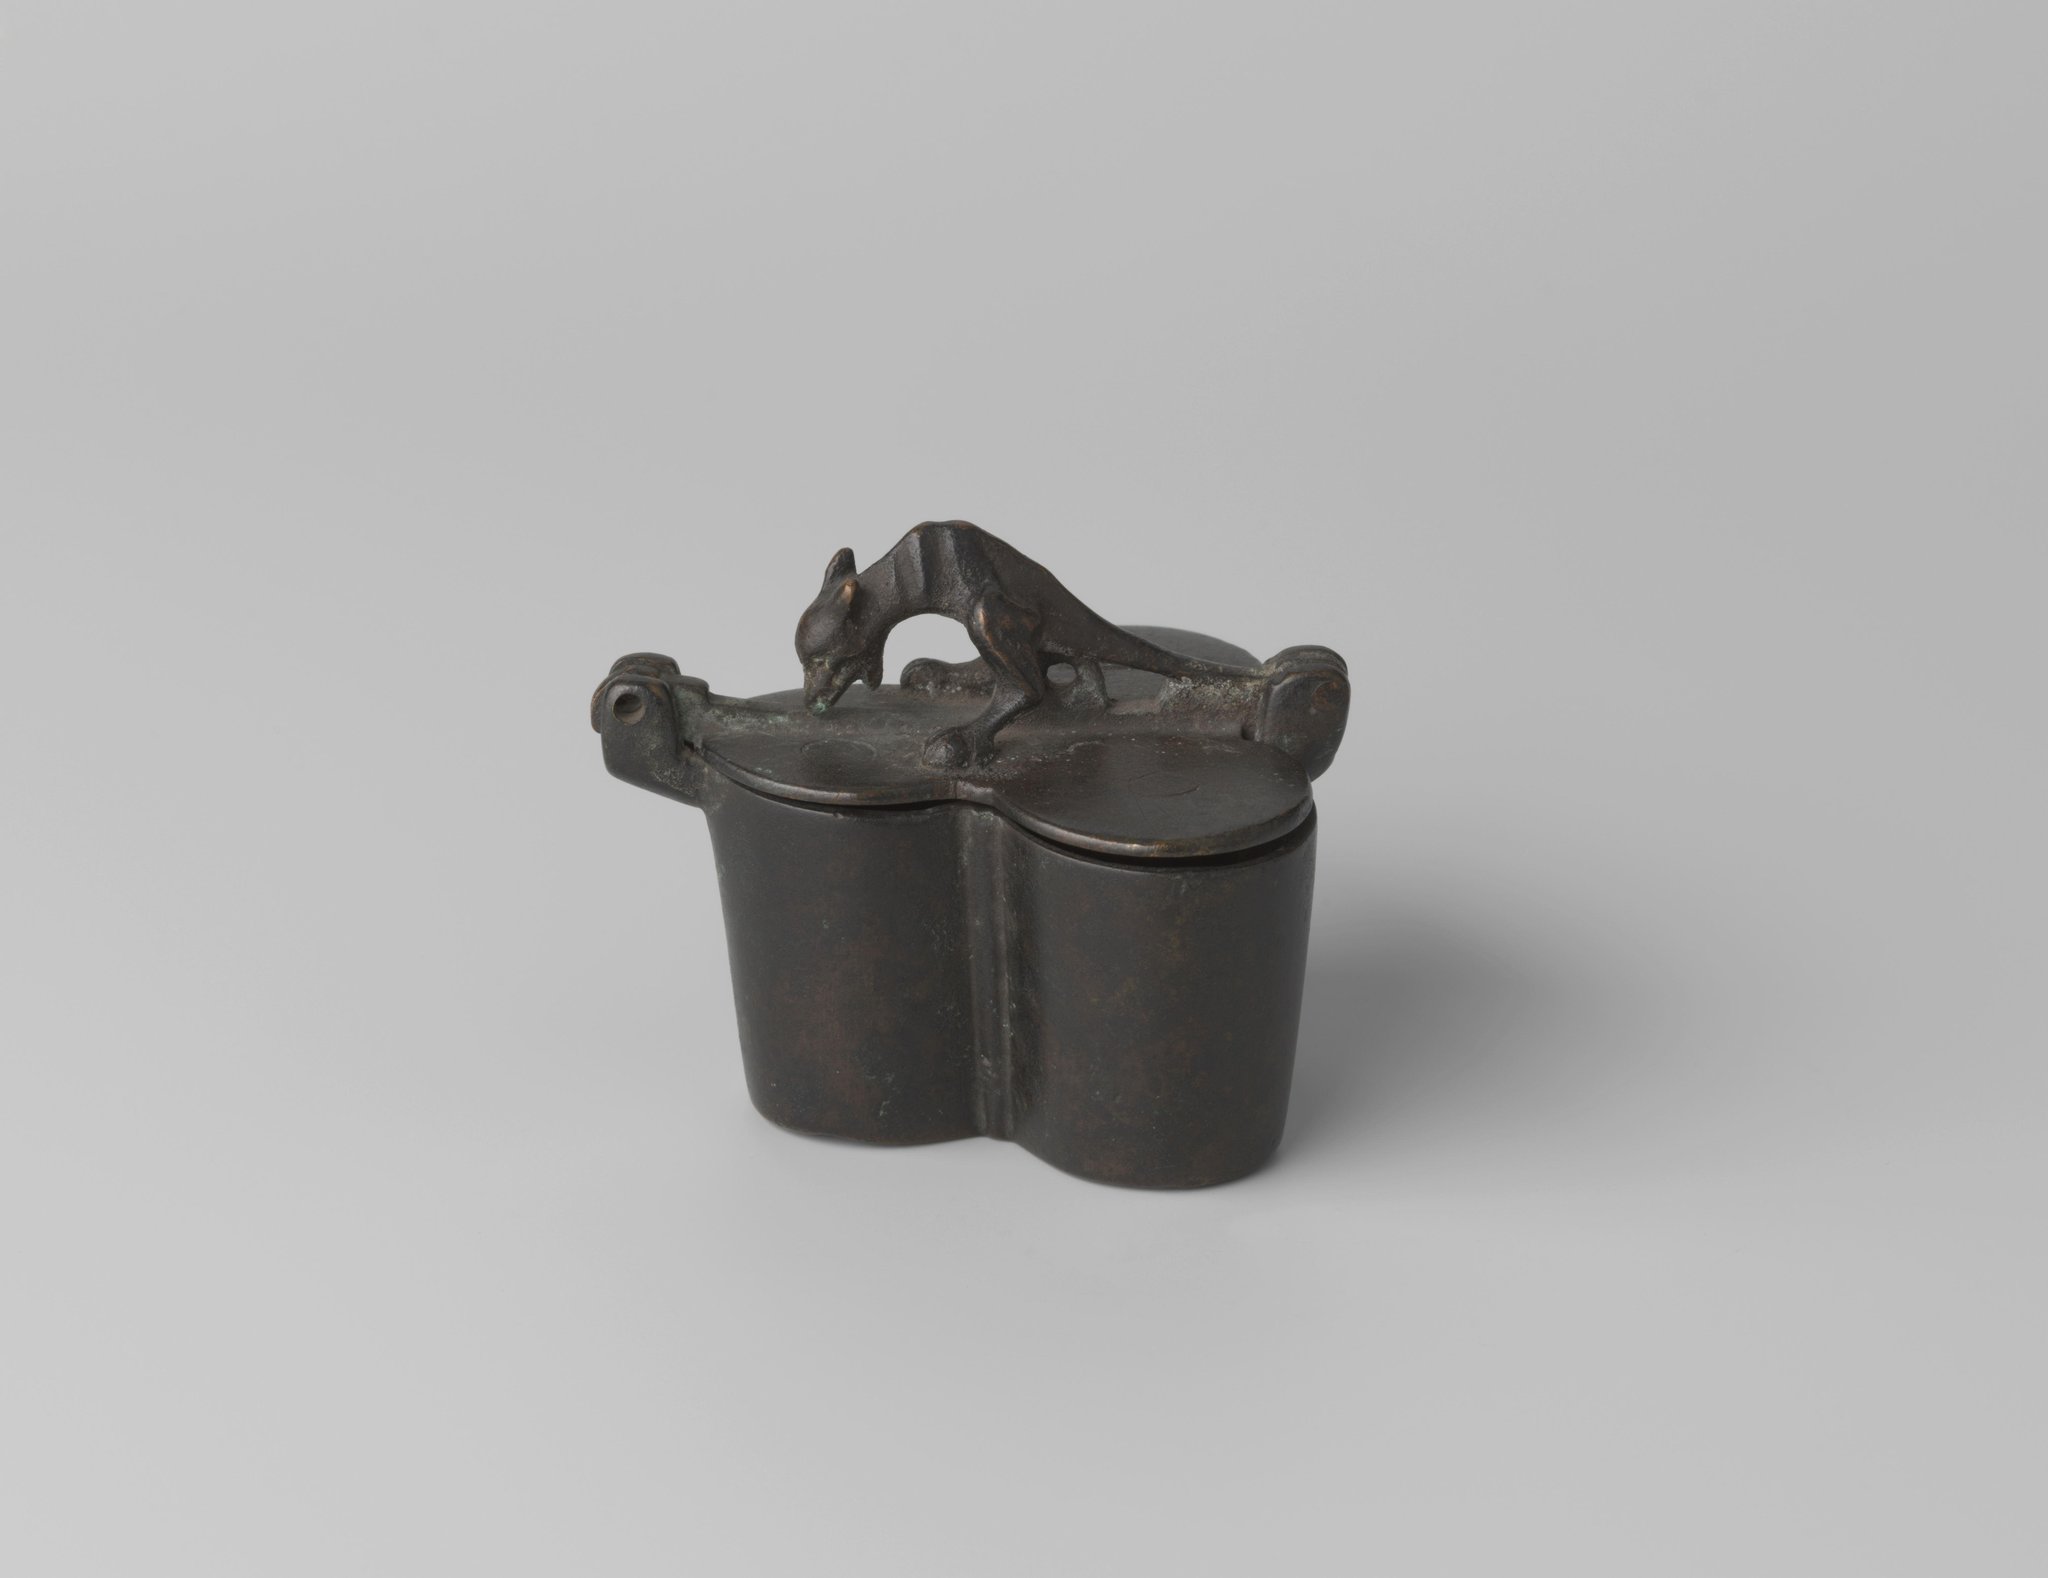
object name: chrismatory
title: Chrismatorium met draakje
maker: Anonymous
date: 1200-1400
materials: bronze, copper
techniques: casting, metalworking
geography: germany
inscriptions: inscription: ‘I, O, C’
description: Chrismatory (container for consecrated oil). Bronze or copper. Germany, 13th or 14th century.